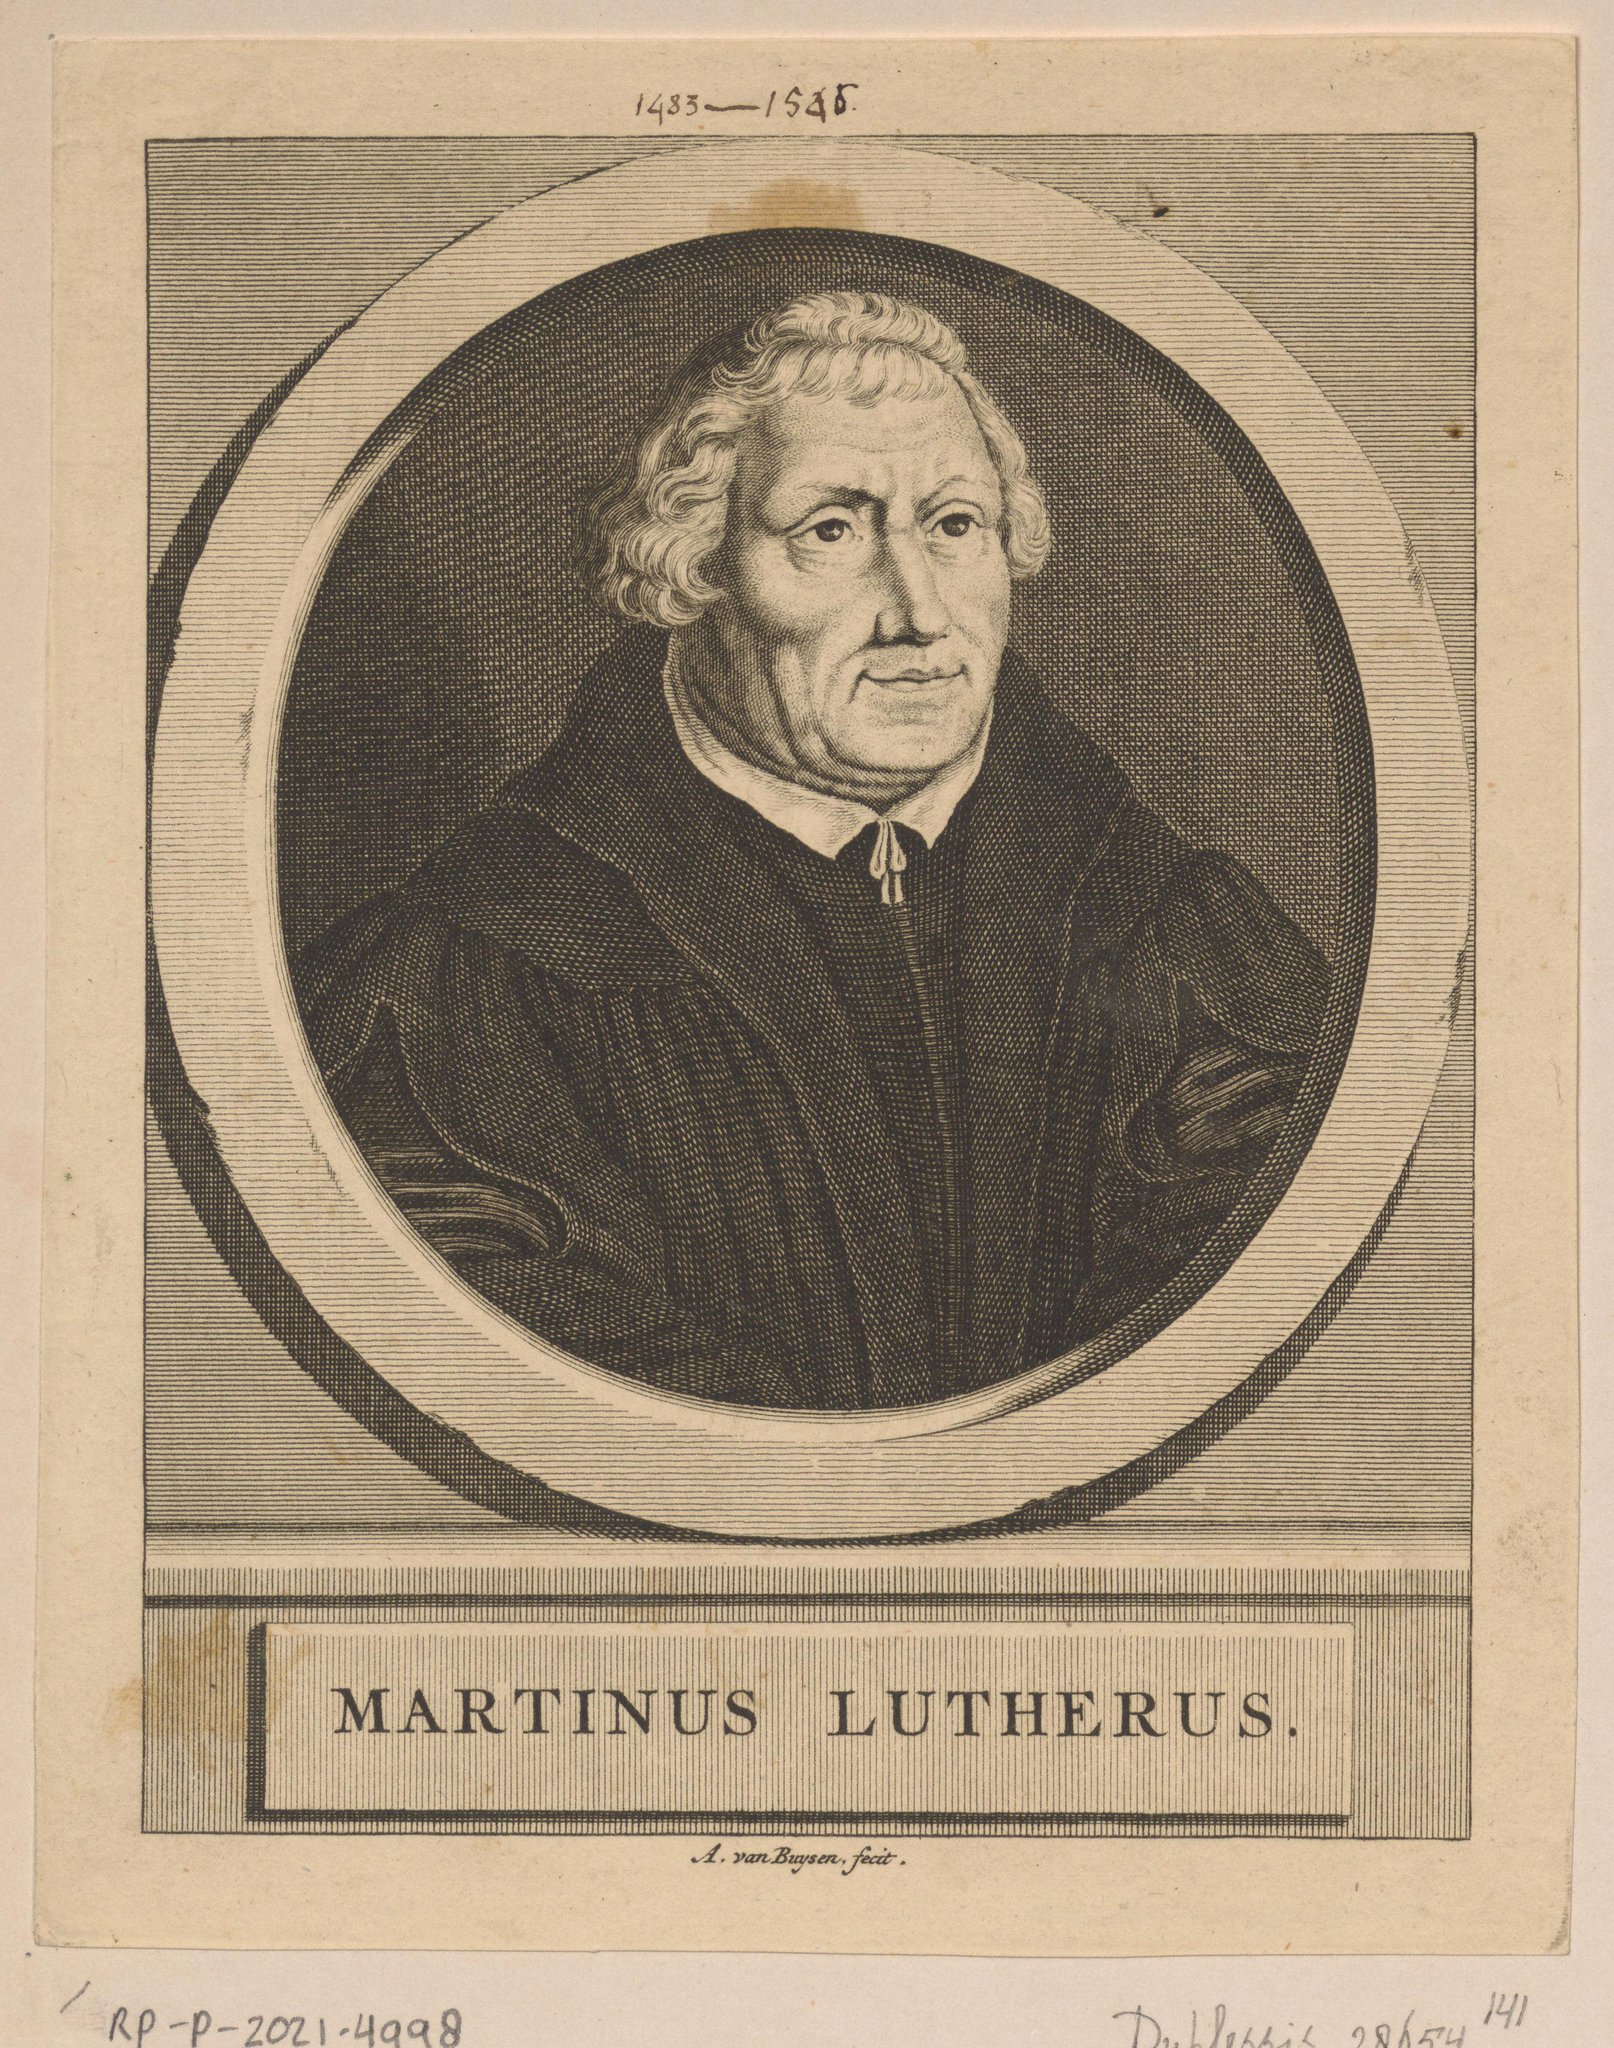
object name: print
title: Portret van Martin Luther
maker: andries van buysen (sr.)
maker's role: print maker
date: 1698-1747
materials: paper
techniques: etching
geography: amsterdam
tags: priest, martin luther, theologian, ornament ~ medallion, historical persons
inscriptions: inscription: ‘1483-1546’